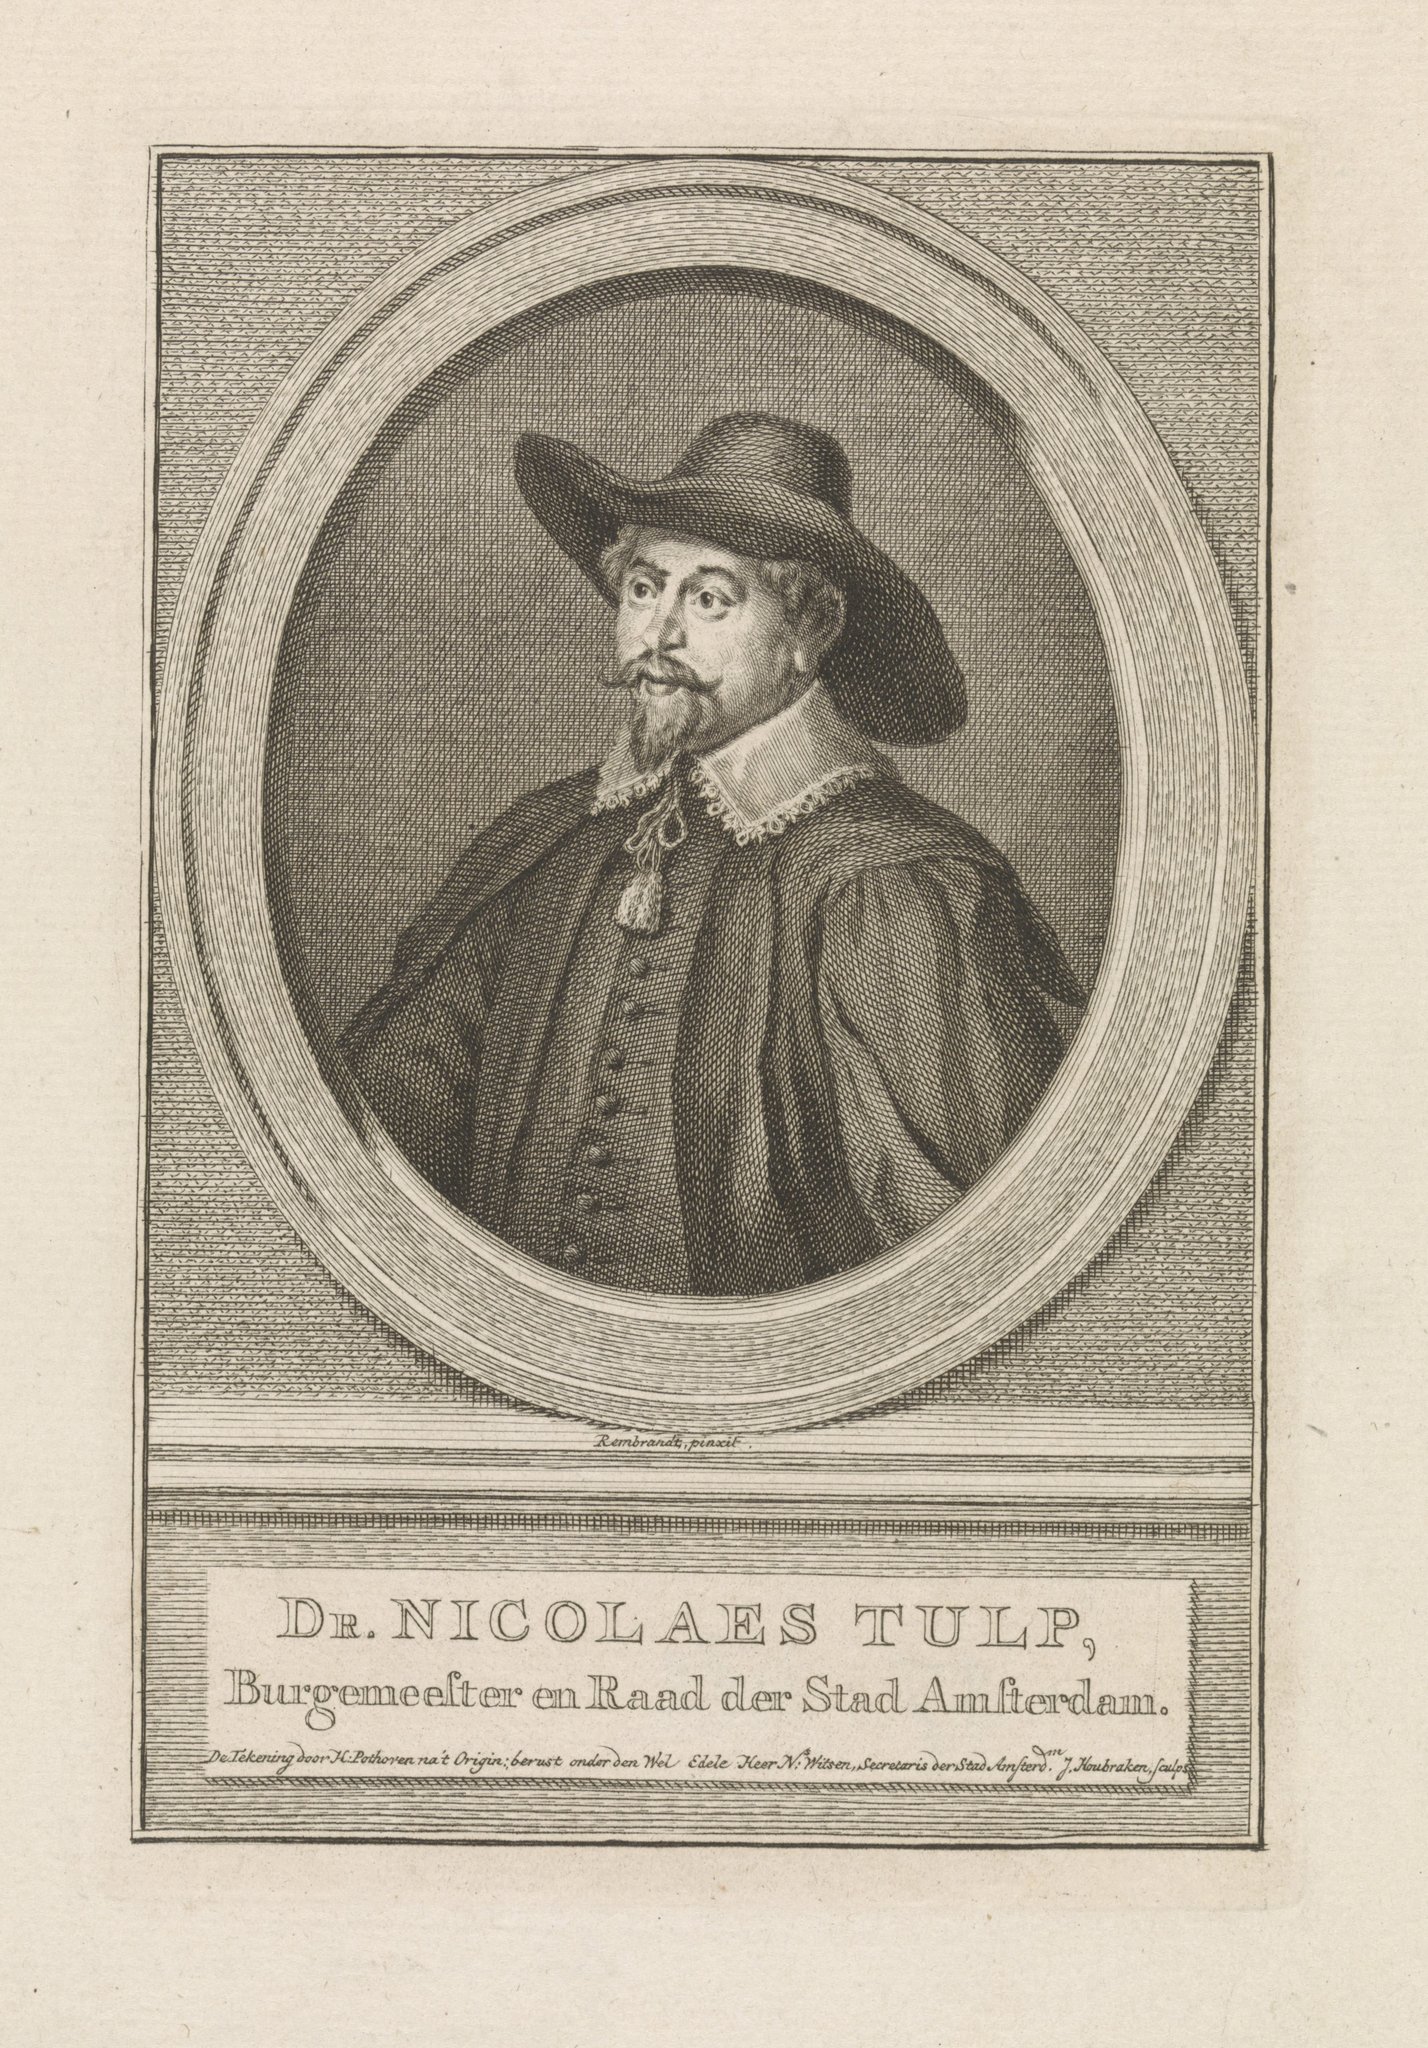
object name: print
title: Portret van Nicolaes Tulp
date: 1749-1780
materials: paper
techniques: engraving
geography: amsterdam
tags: the hague, mayor, historical persons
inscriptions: collector's mark: Lugt 2228, inscription: ‘Geb. 11 Oct.1593. Overl. 12 Sept.1674/ begraven in de Nieuwe Kerk, nabij/ het Oude Heilige Kruiskoor: thans de/ uitdeelingsplaats der Diaconie. No130’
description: Deze prent is oorspronkelijk bedoeld als aanvulling op Jan Wagenaars ‘Vaderlandsche historie’* en was zo vanaf 1796 verkrijgbaar bij Johannes Allart te Amsterdam. Voor de advertentie waarin Allart de 60 portretten en 7 platen, allen gegraveerd door Houbraken, ter aanvulling op Wagenaars ‘Vaderlandsche historie’ aanbiedt, zie RP-P-OB-77.766. *Van dit werk zijn in de achttiende eeuw meerdere uitgaves verschenen, zoals: Wagenaar, Jan. Vaderlandsche historie, vervattende de geschiedenissen der Vereenigde Nederlanden (…). 21 delen. Amsterdam: Isaak Tirion, 1749-1759. Wagenaar, Jan. Vaderlandsche historie, vervattende de geschiedenissen der nu Vereenigde Nederlanden (…). 21 delen. Amsterdam: weduwe Isaak Tirion, 1770. Wagenaar, Jan. Vaderlandsche historie, vervattende de geschiedenissen der nu Vereenigde Nederlanden (…). 21 delen. Amsterdam, Leiden, Dordrecht en Harlingen: P. Schouten e.a., 1782. Wagenaar, Jan. Vaderlandsche historie, vervattende de geschiedenissen der nu Vereenigde Nederlanden (…). 21 delen. Amsterdam: Johannes Allart, 1790-1796.